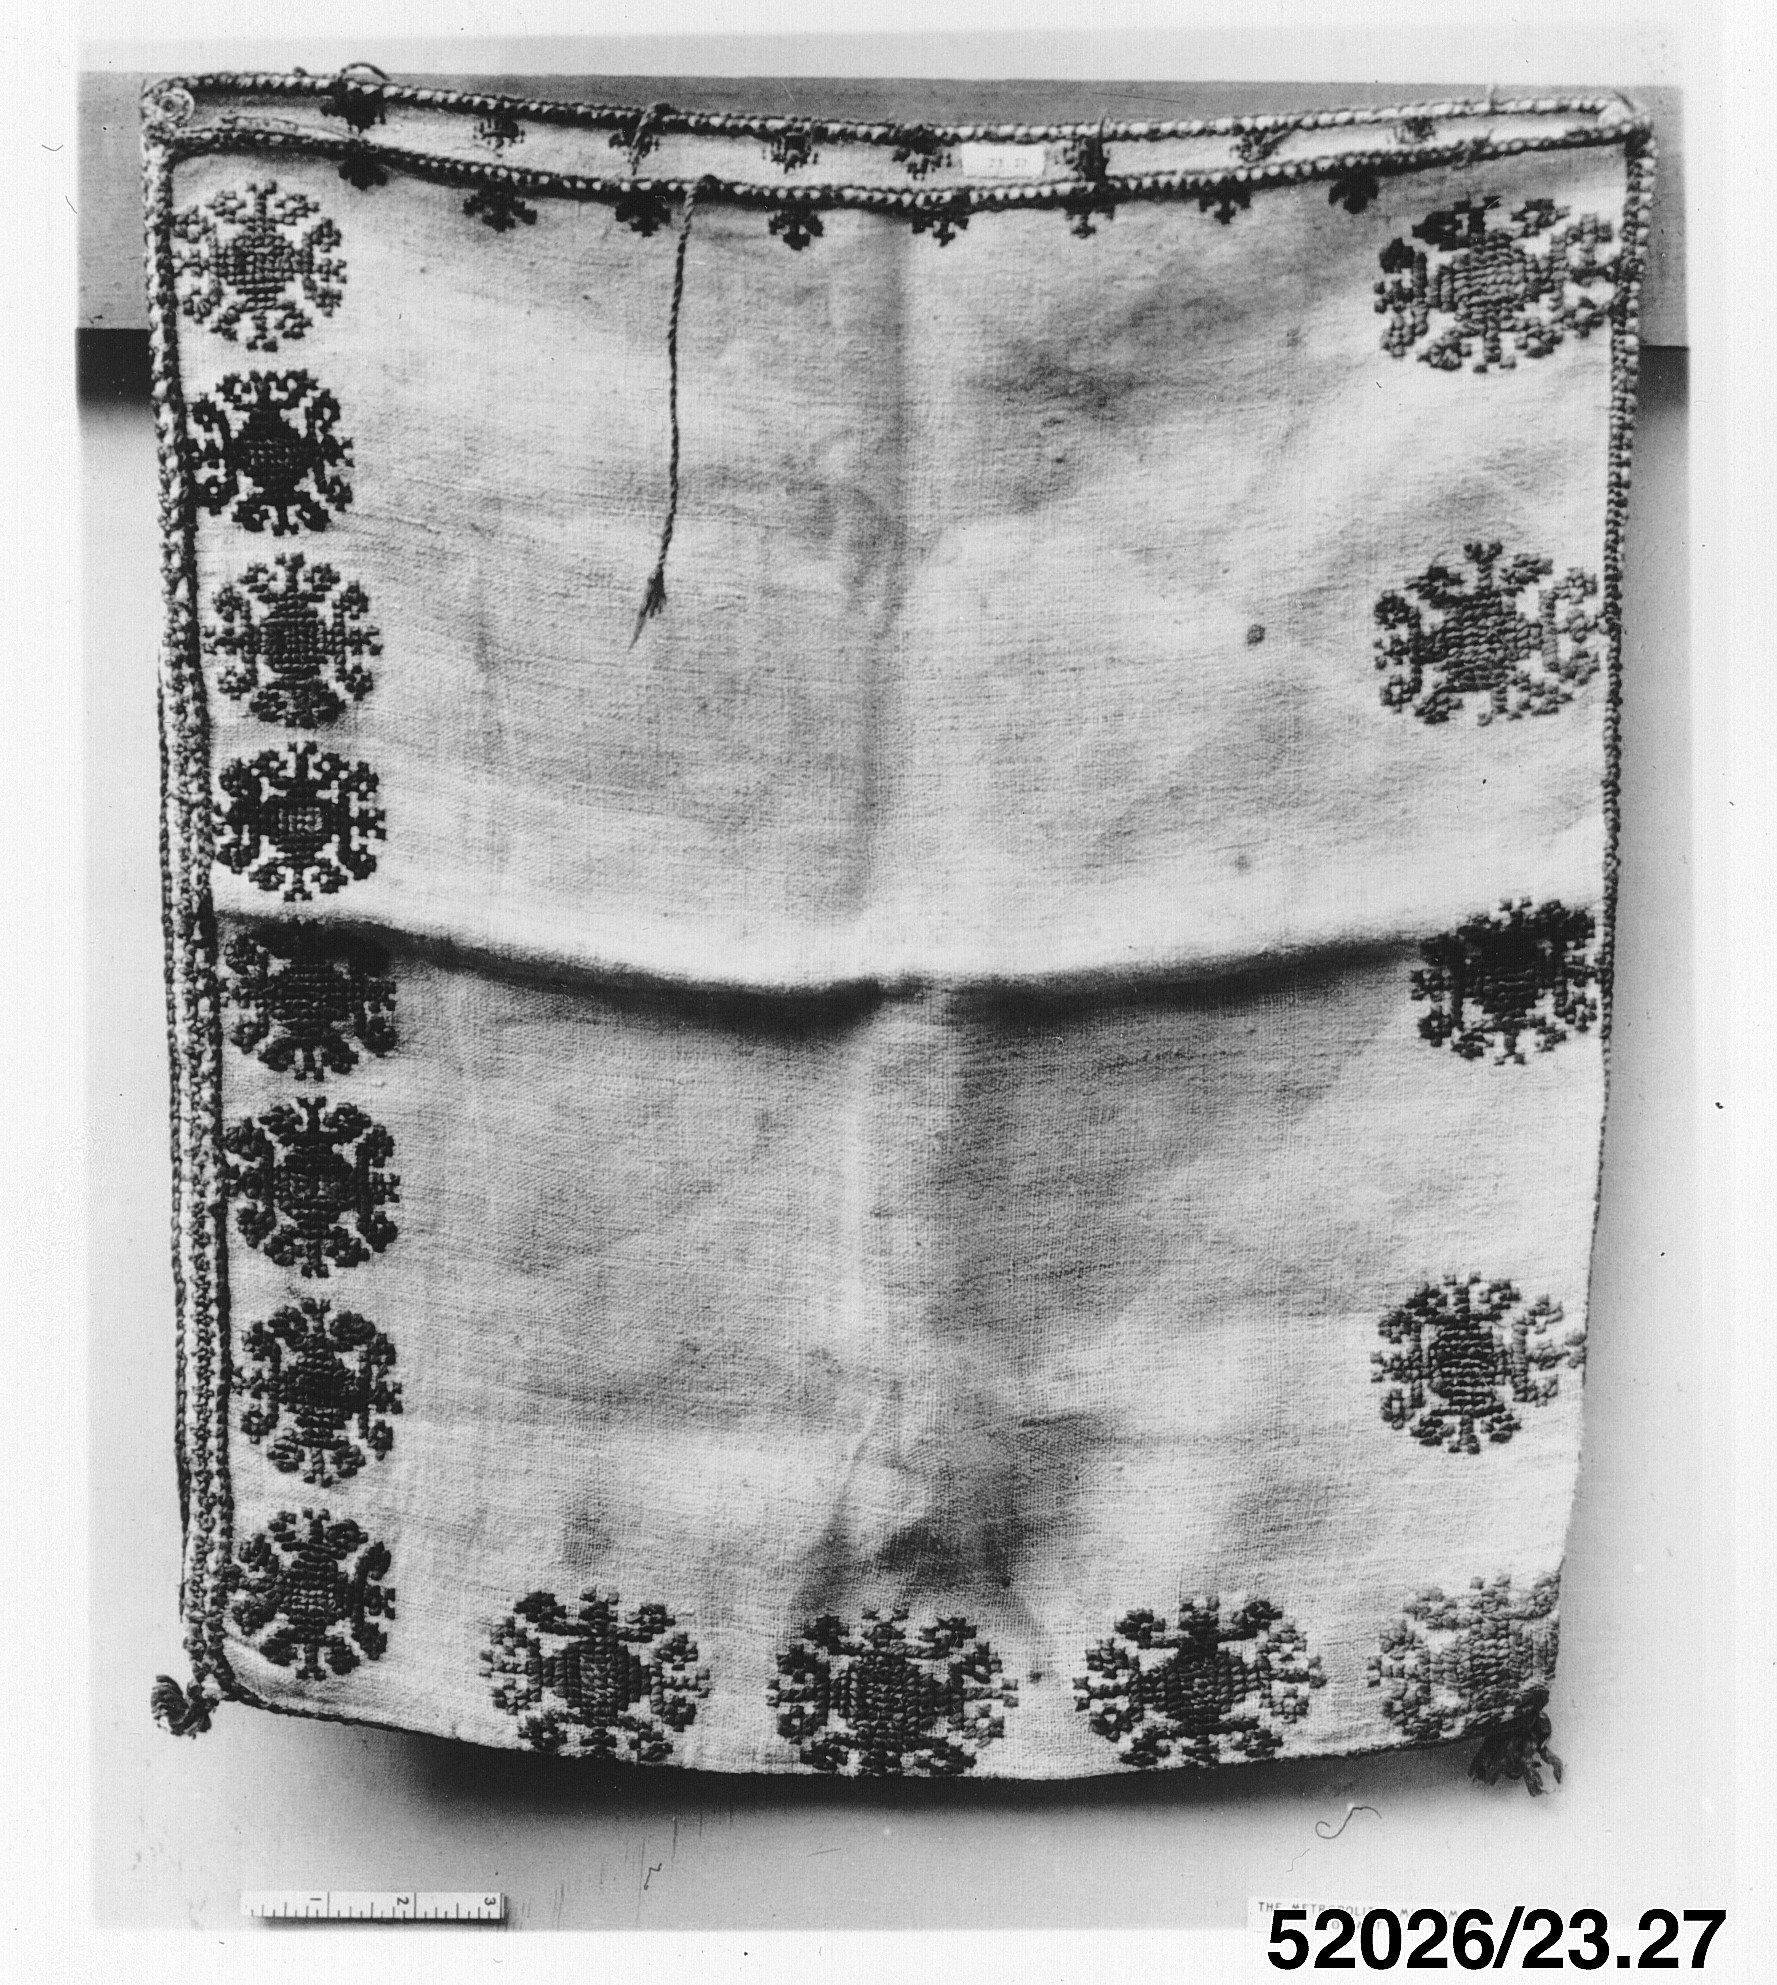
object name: pillowcase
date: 1701-1800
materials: linen, silk